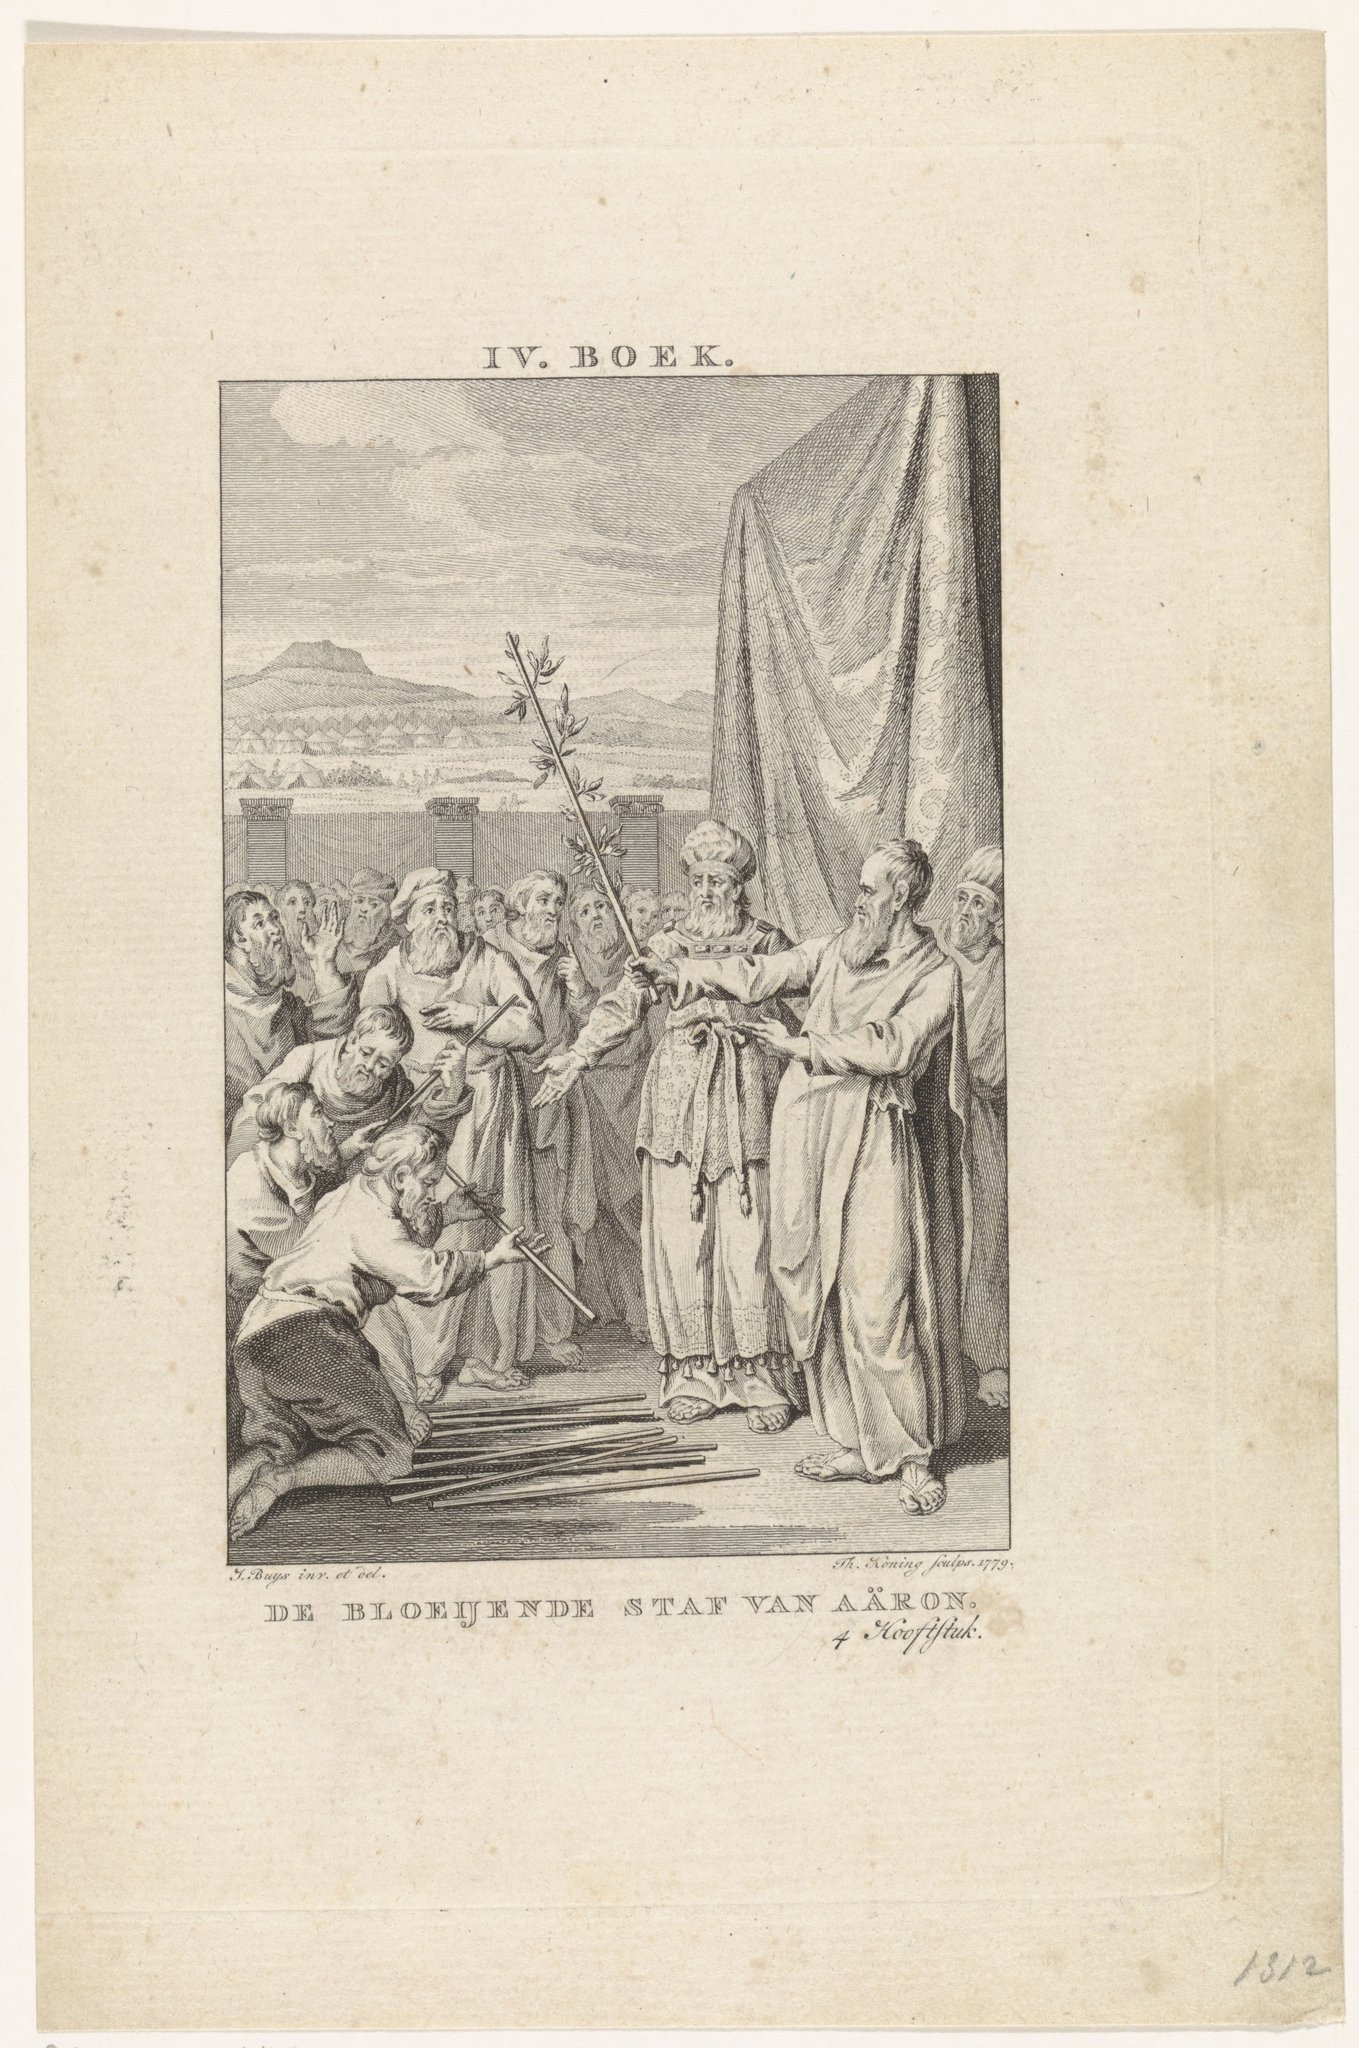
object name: book illustration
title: Bloeiende staf van Aäron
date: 1779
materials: paper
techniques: engraving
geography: amsterdam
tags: moses shows the flowering rod of aaron to the community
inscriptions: collector's mark: Lugt 2228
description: Mozes komt met de bloeiende staf van Aäron uit de verbondstent. Voor hem zitten de stamhoofden van Israël, die hun staf weer in ontvangst nemen. Op de achtergrond is een tentenkamp te zien (Num. 17:22-24). Deze prent is een illustratie bij het vierde hoofdstuk van het vierde boek van 'Alle de werken van Flavius Josephus'.